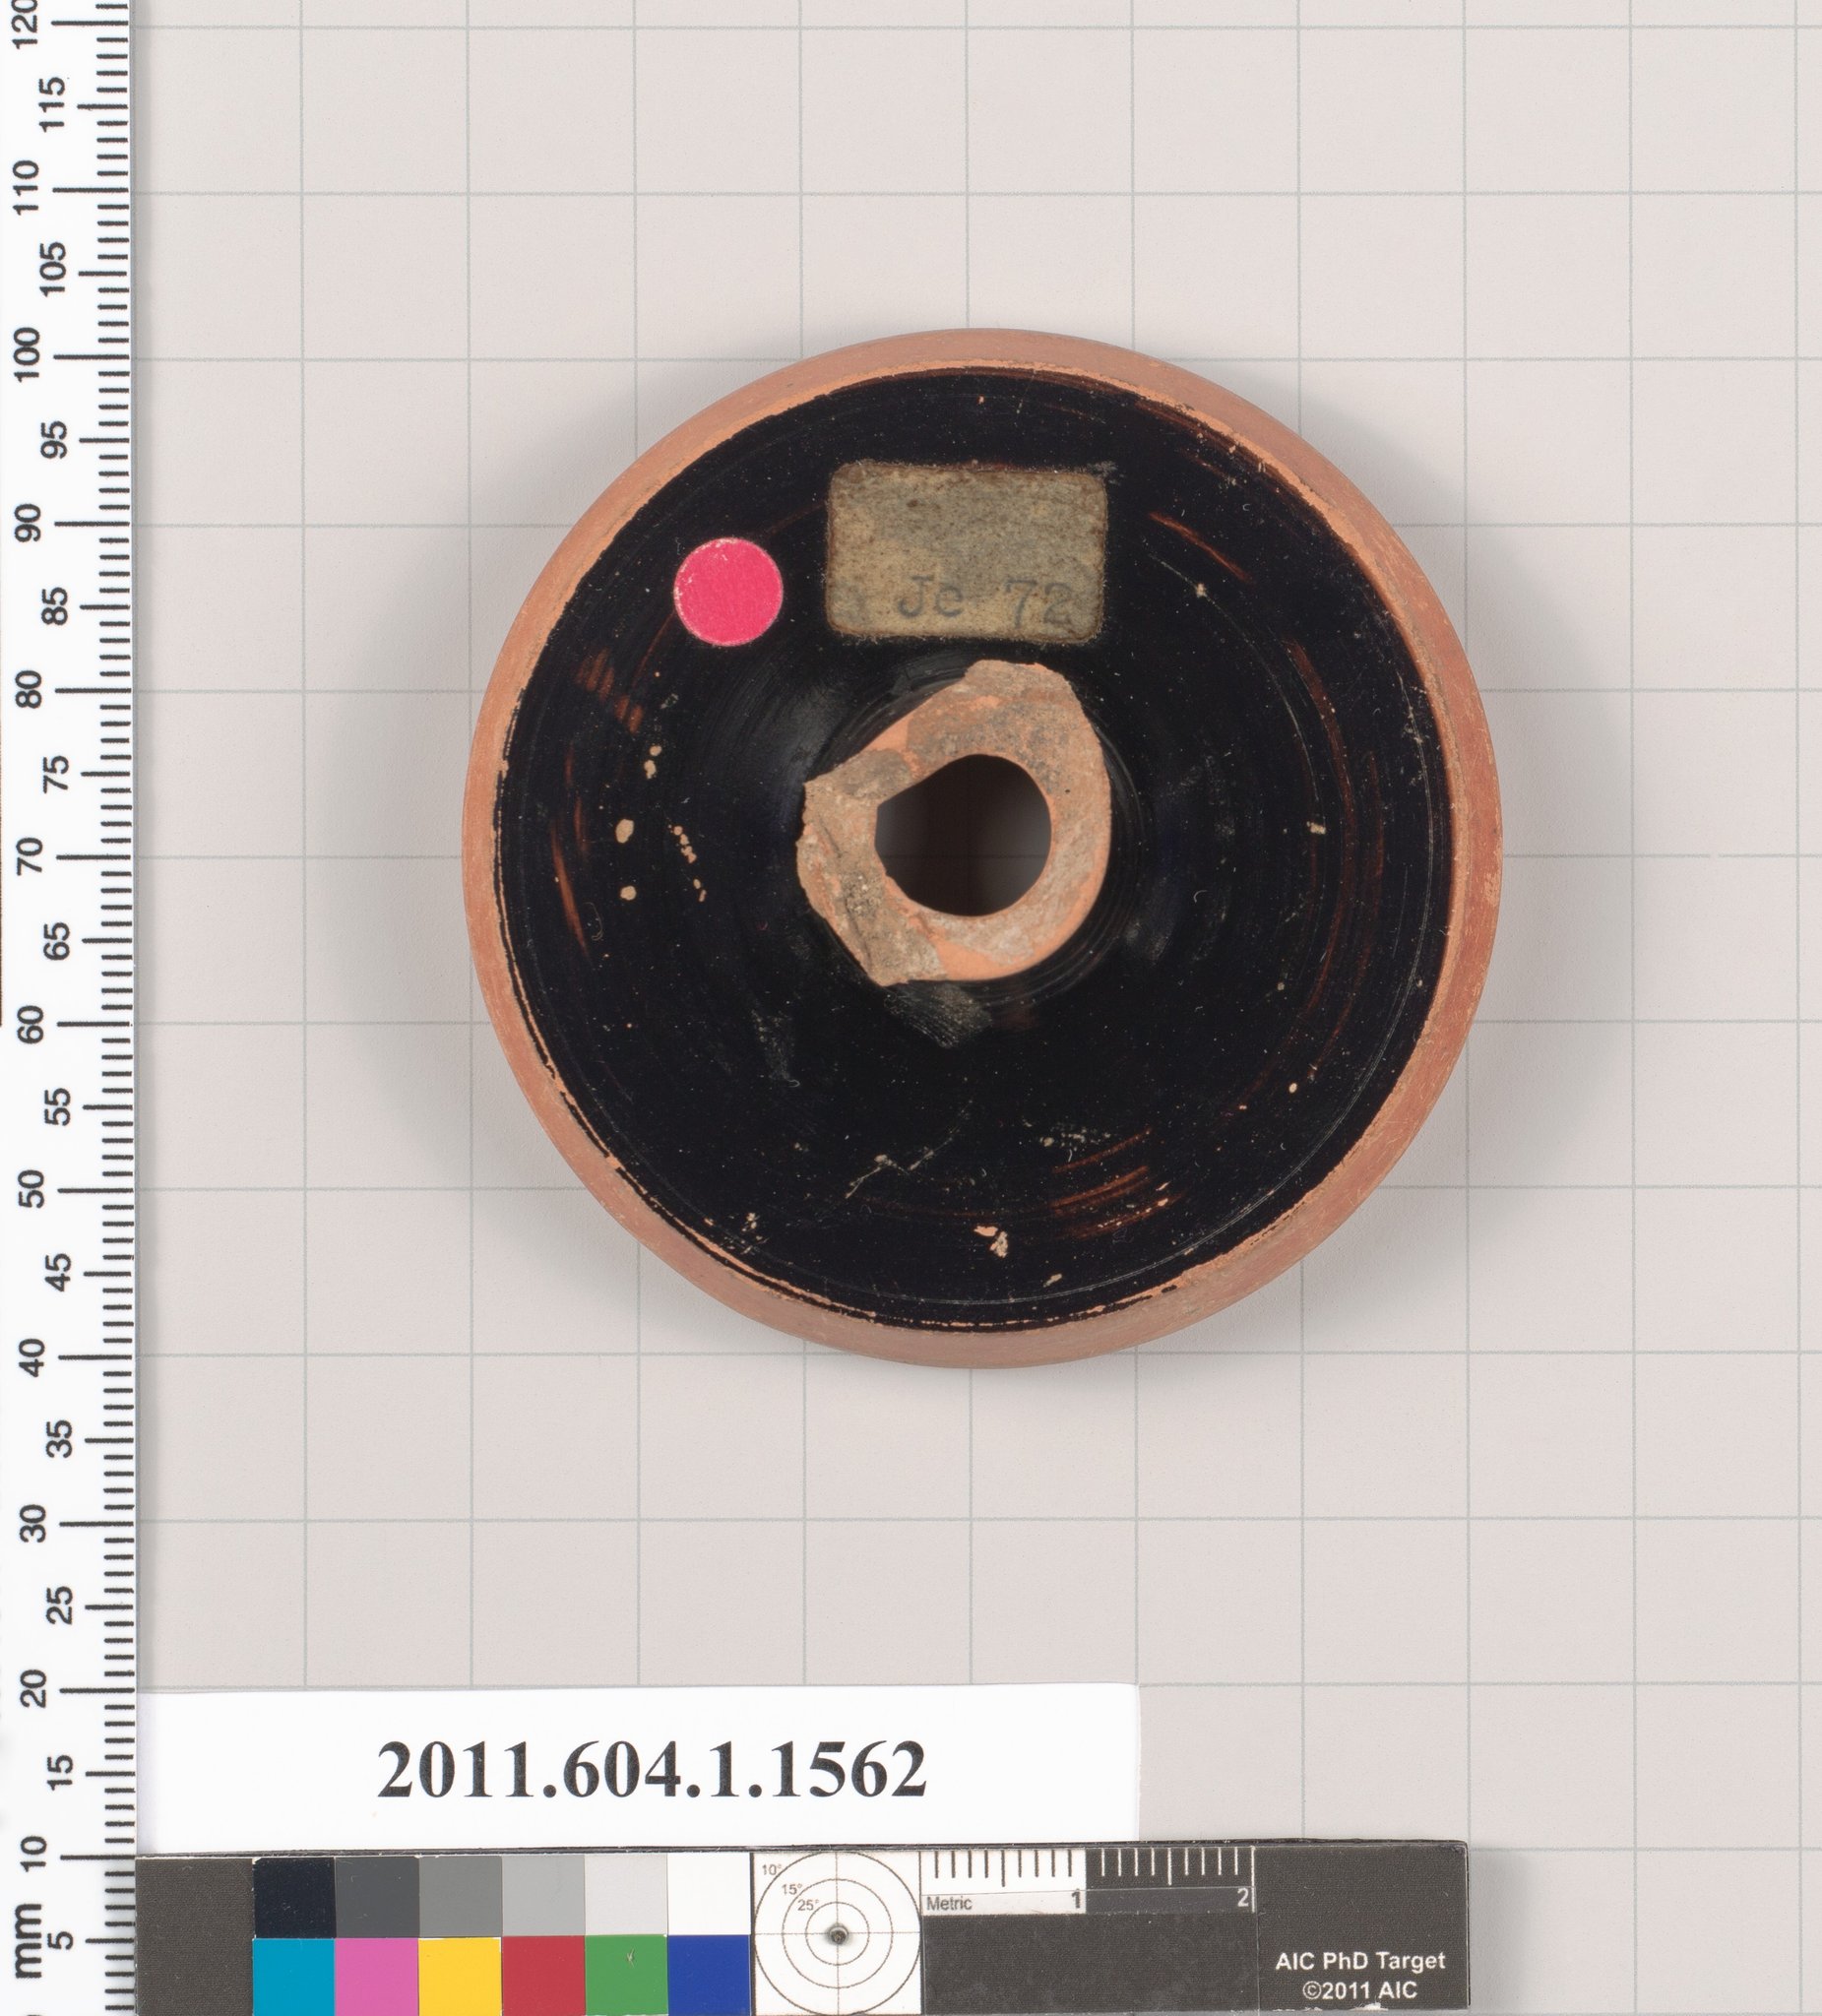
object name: kylix fragment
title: Terracotta fragment of a kylix (drinking cup)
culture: greek, attic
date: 480-470 BCE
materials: terracotta